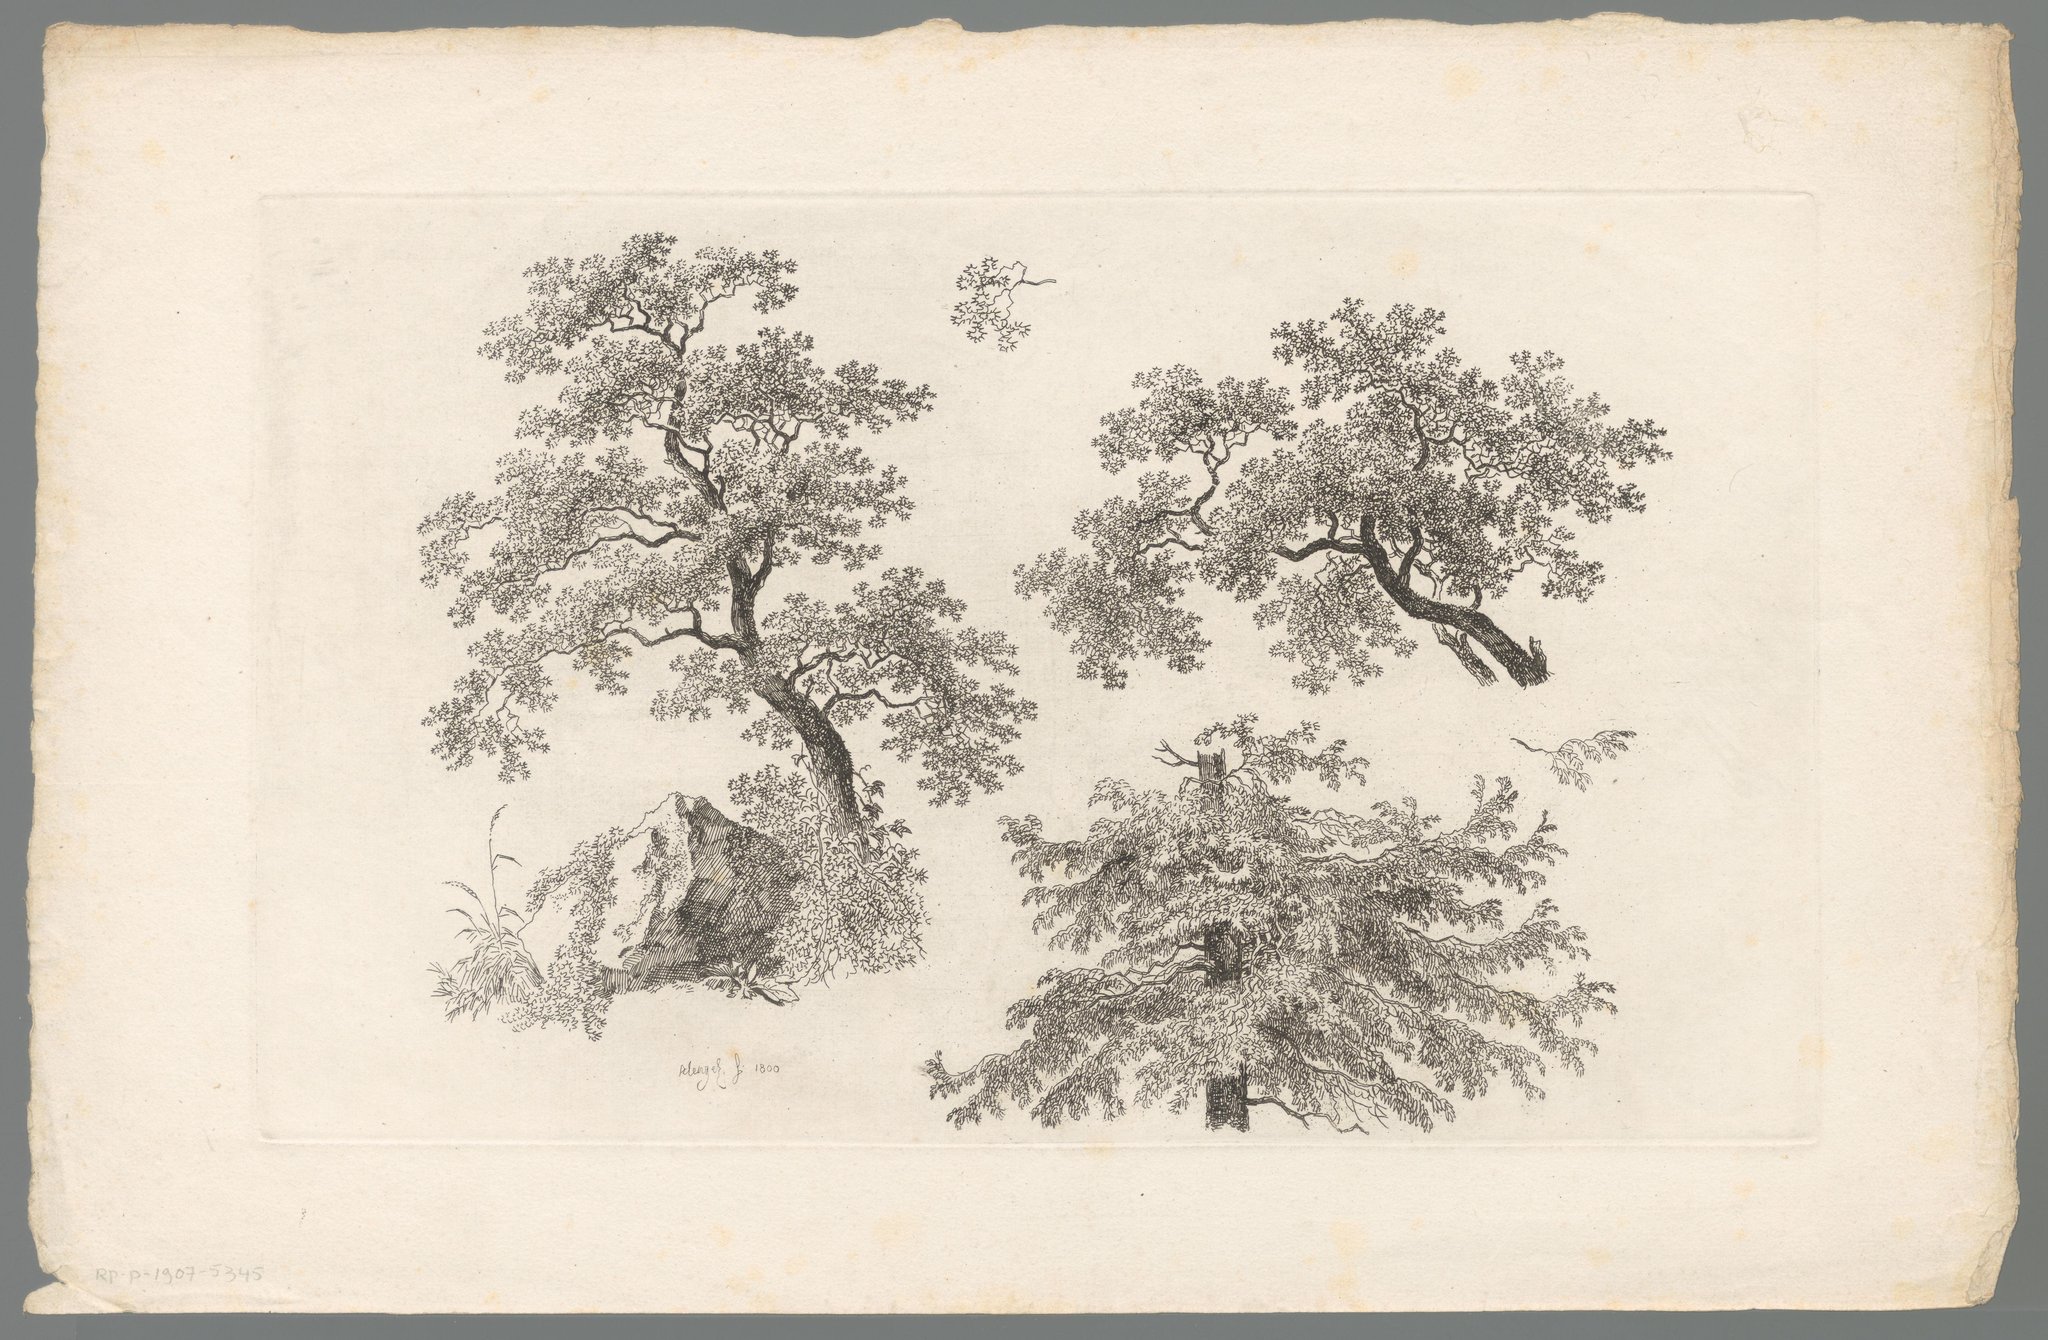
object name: print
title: Studie van boomtakken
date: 1800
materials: paper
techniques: etching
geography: dresden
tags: trees, foliage, tendrils, branches ~ ornament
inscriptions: collector's mark: Lugt 2228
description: Prent hoort bij de uitgave: Klengel, Johann Christian. Principes de Dessein pour Les Paysages par J.C. Klengel, professeur de l'Academie Electorale de Peinture a Dresde. Se vend chez Henry Rittner au Magazin des Beaux Arts Rue de Chateau no. 329 a Dresde. Dresden: Heinrich Rittner, 1802.